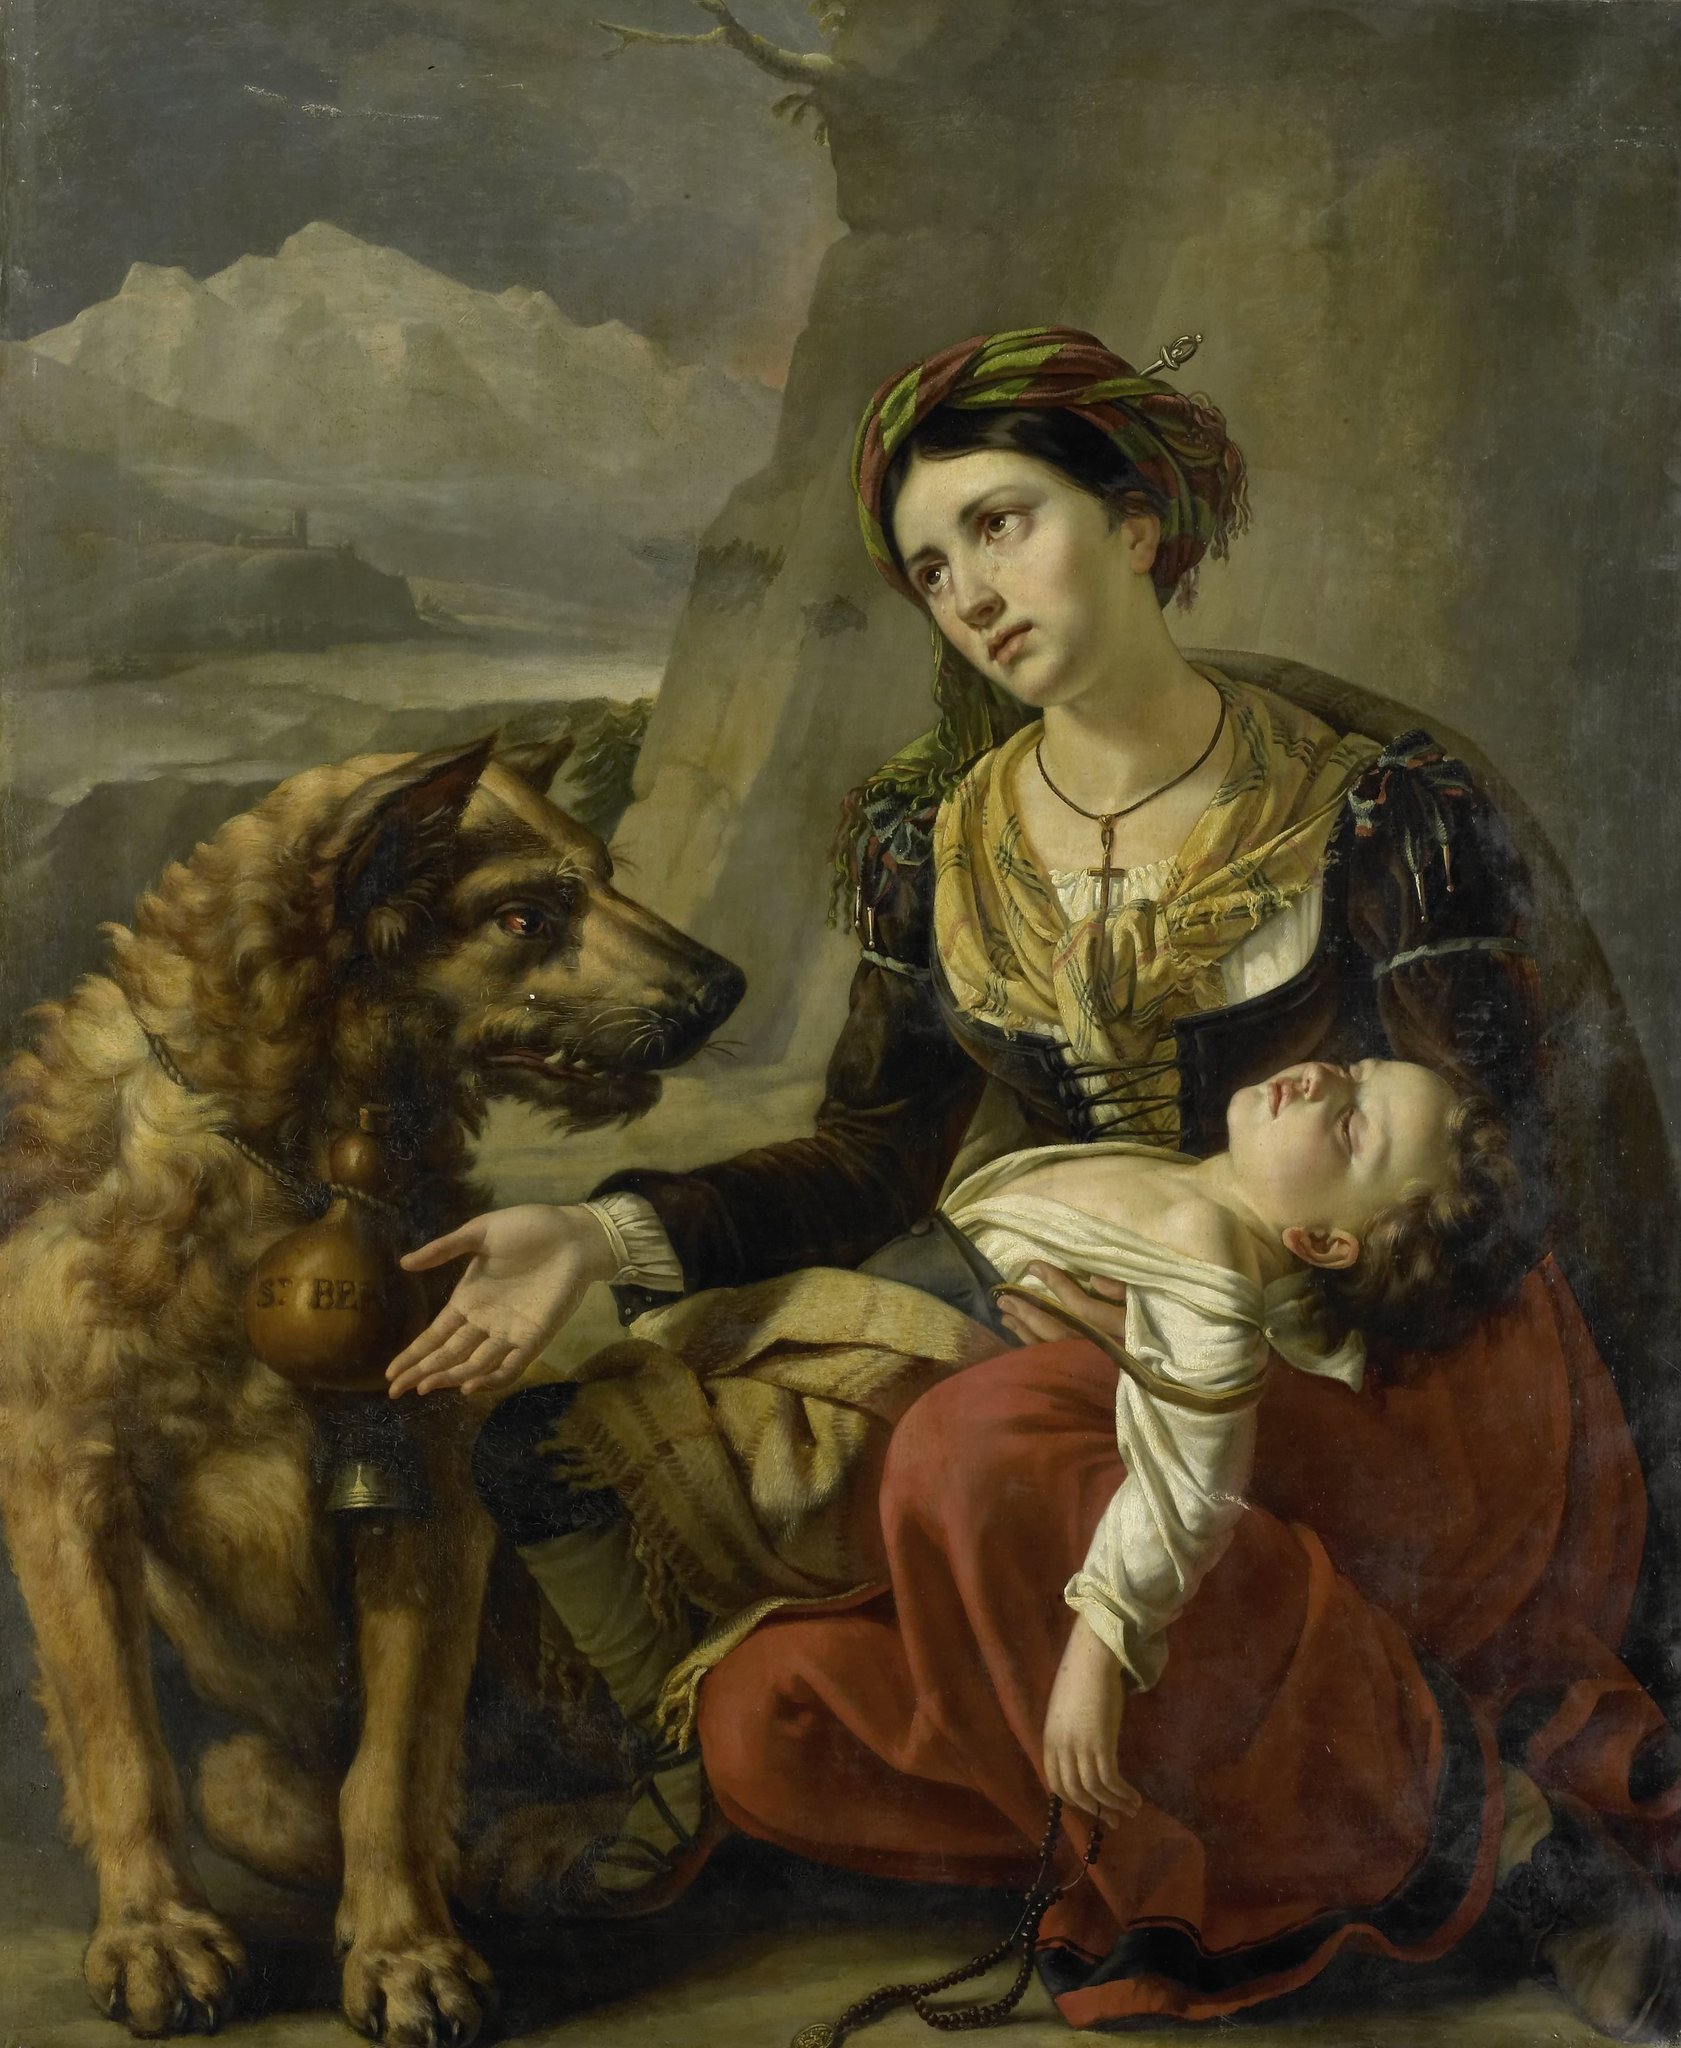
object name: painting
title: A Saint Bernard Dog Comes to the Aid of a lost Woman with a sick Child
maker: charles picqué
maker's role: designer, painter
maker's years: 1799-1869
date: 1827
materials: canvas, oil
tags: dog (st.bernard), training of dogs, nursing, tending the sick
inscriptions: signature and date: ‘C. Picqué 1827’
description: Een sint-bernardshond komt een in de bergen verdwaalde vrouw met een ziek kind te hulp. Rechts knielt de vrouw tegen een rotswand met het kind liggend op haar schoot; de jongen heeft een rozenkrans in de hand. Links zit een hond met om de nek een kruik (gemerkt St. Bern.) en een bel.